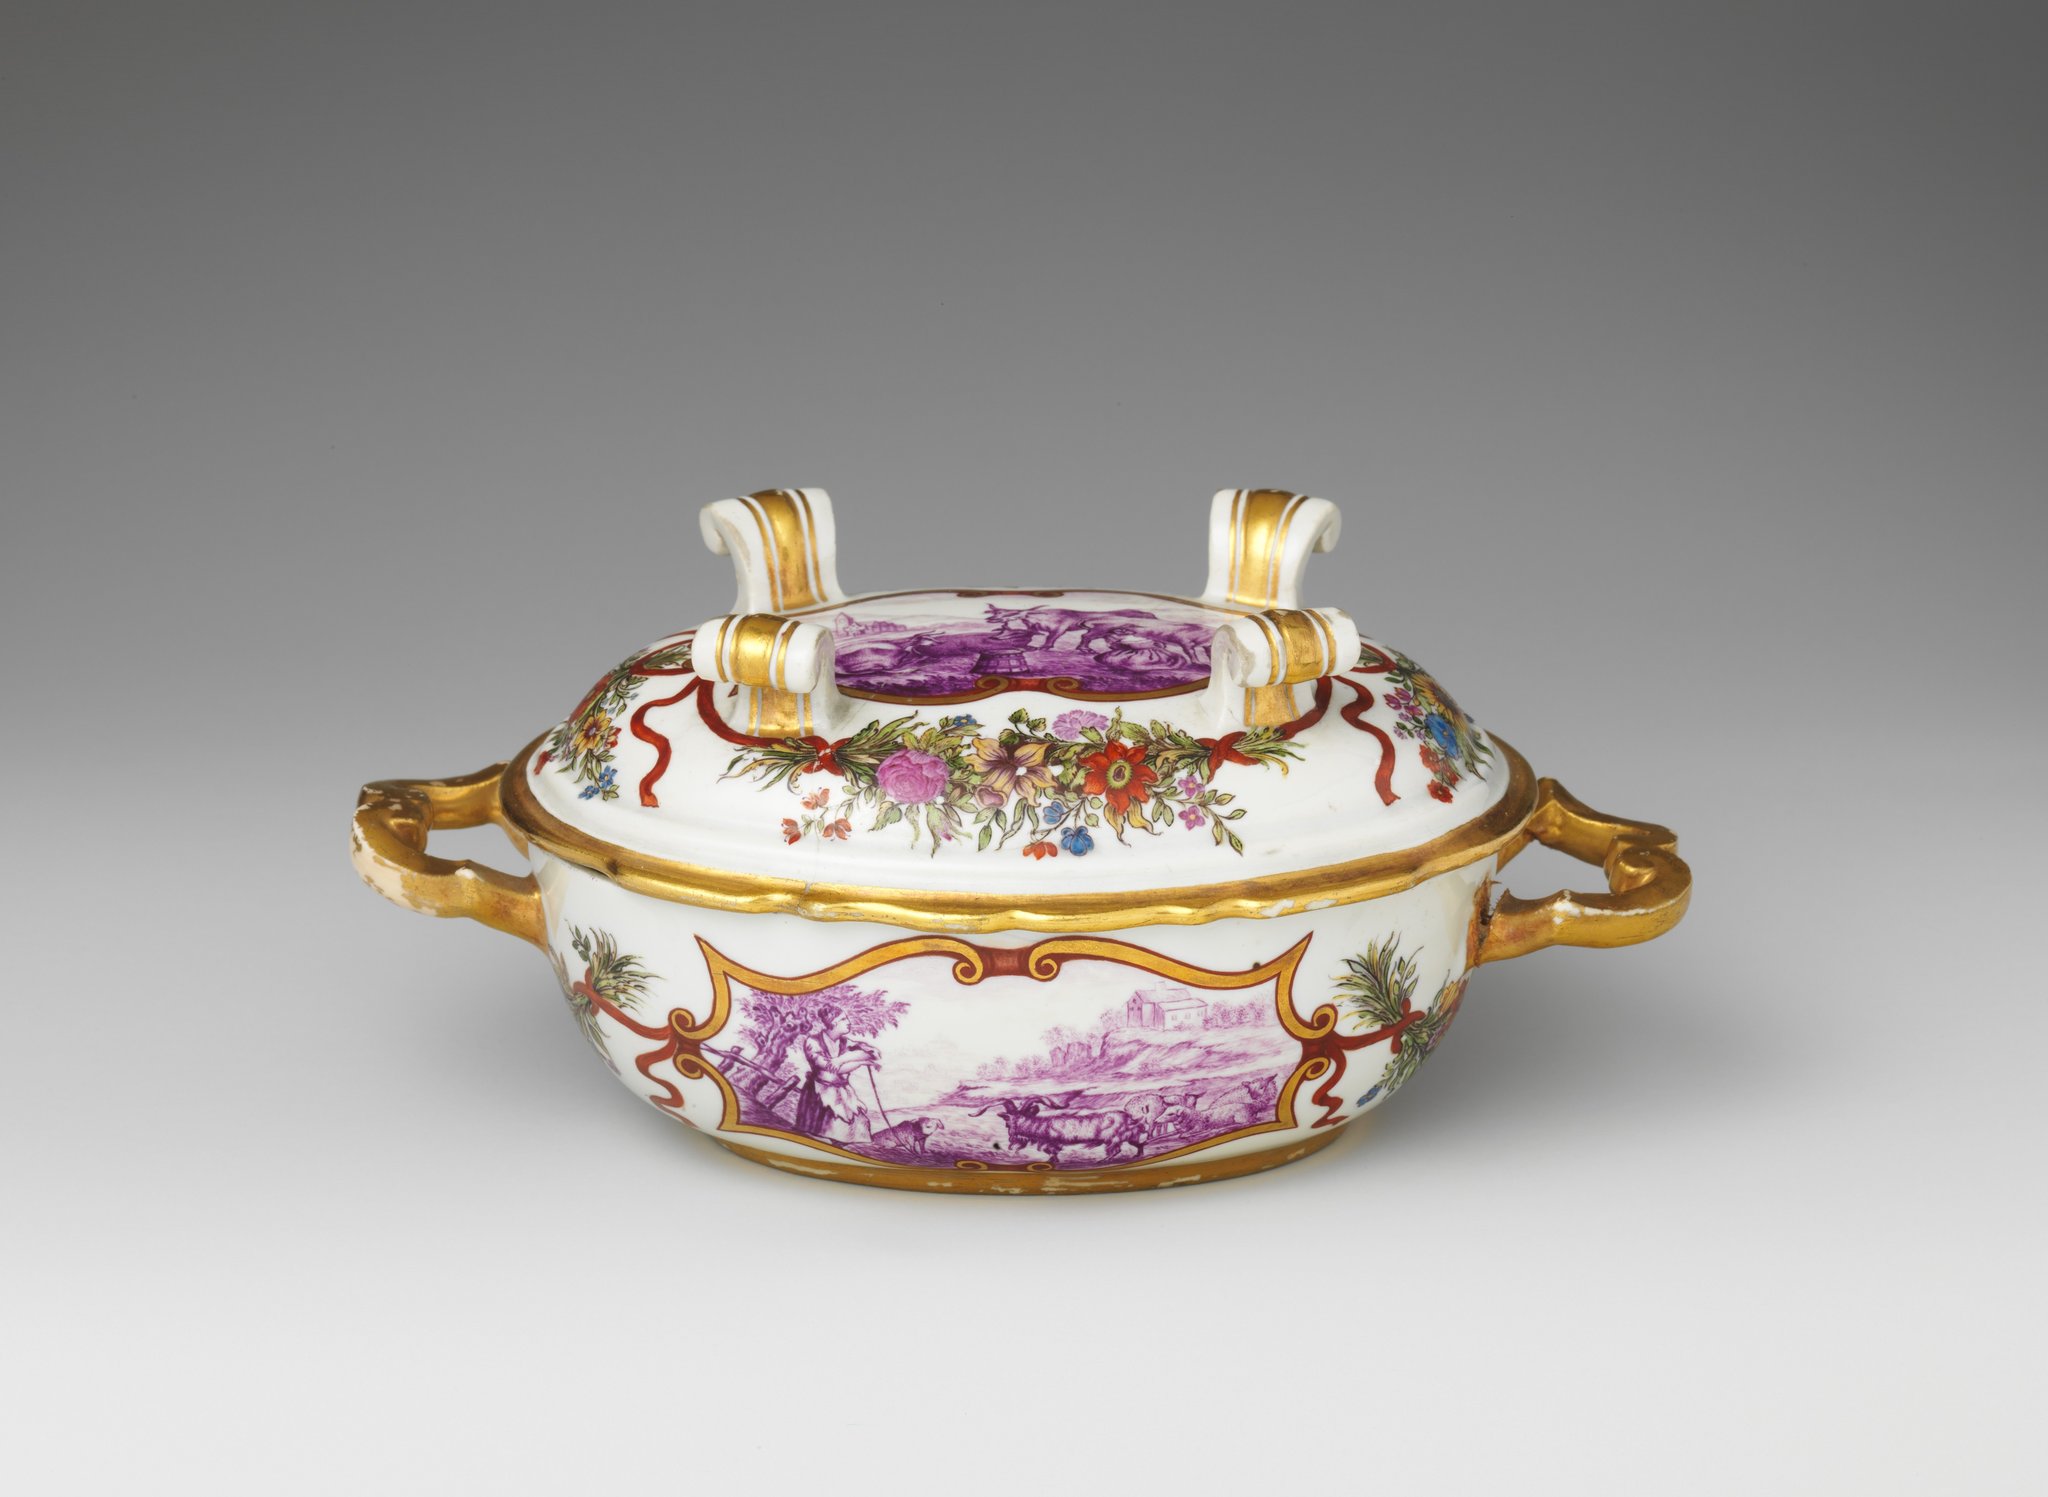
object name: dish with cover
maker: vienna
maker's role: manufactory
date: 1734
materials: hard paste porcelain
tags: animals,men,flowers